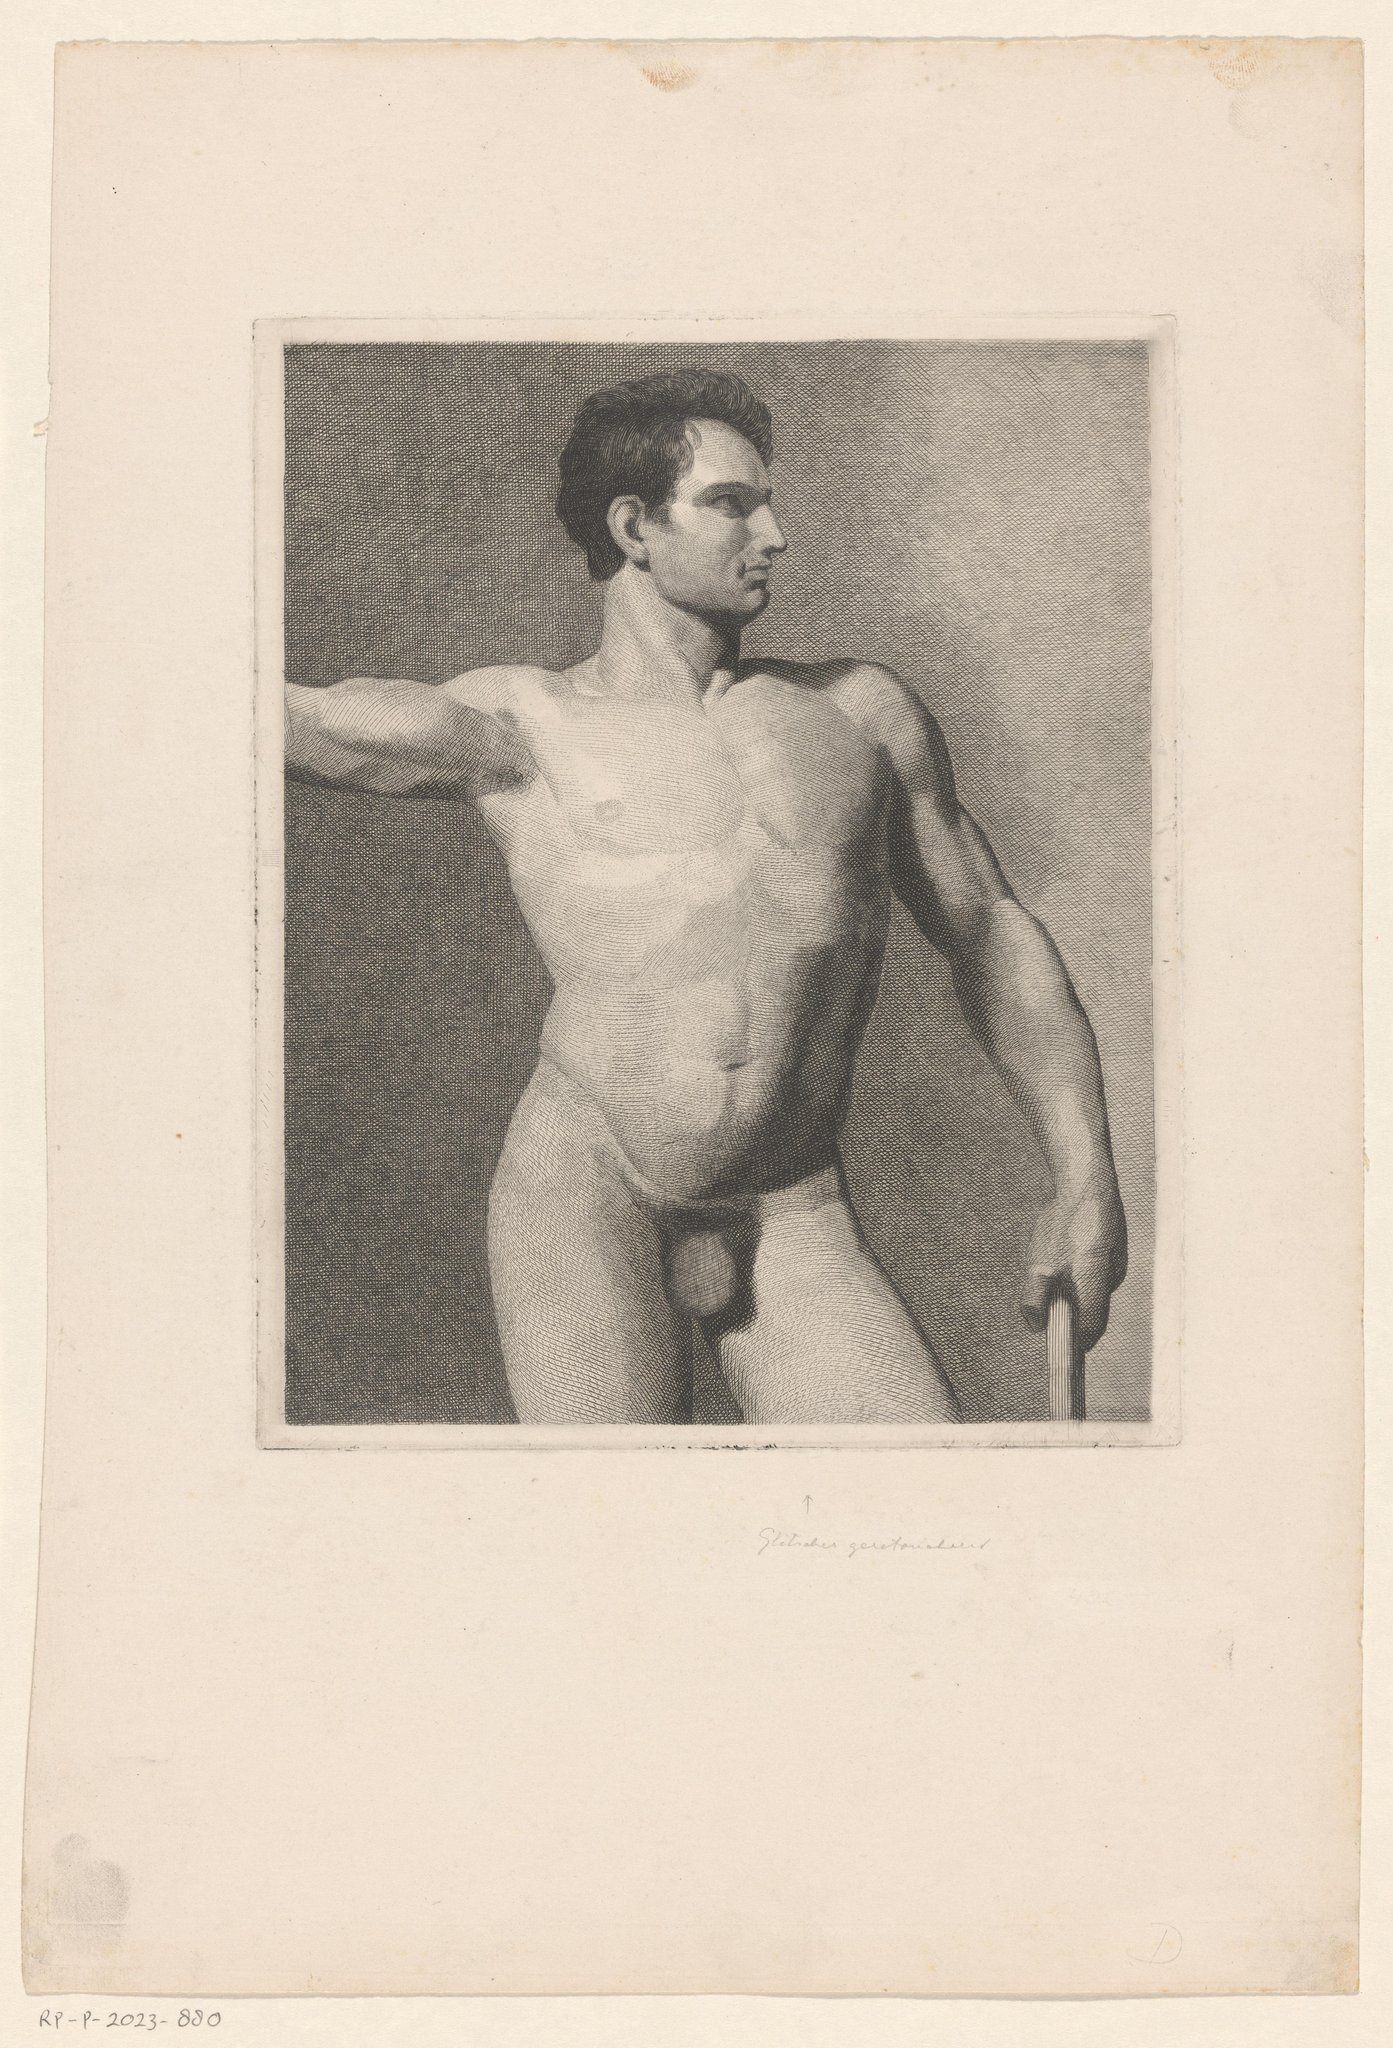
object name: print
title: Staande naakte man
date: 1820-1860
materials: paper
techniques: engraving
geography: netherlands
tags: standing figure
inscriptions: collector's mark: Lugt 2228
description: Academiestudie van een staande naakte man, naar rechts, kniestuk.